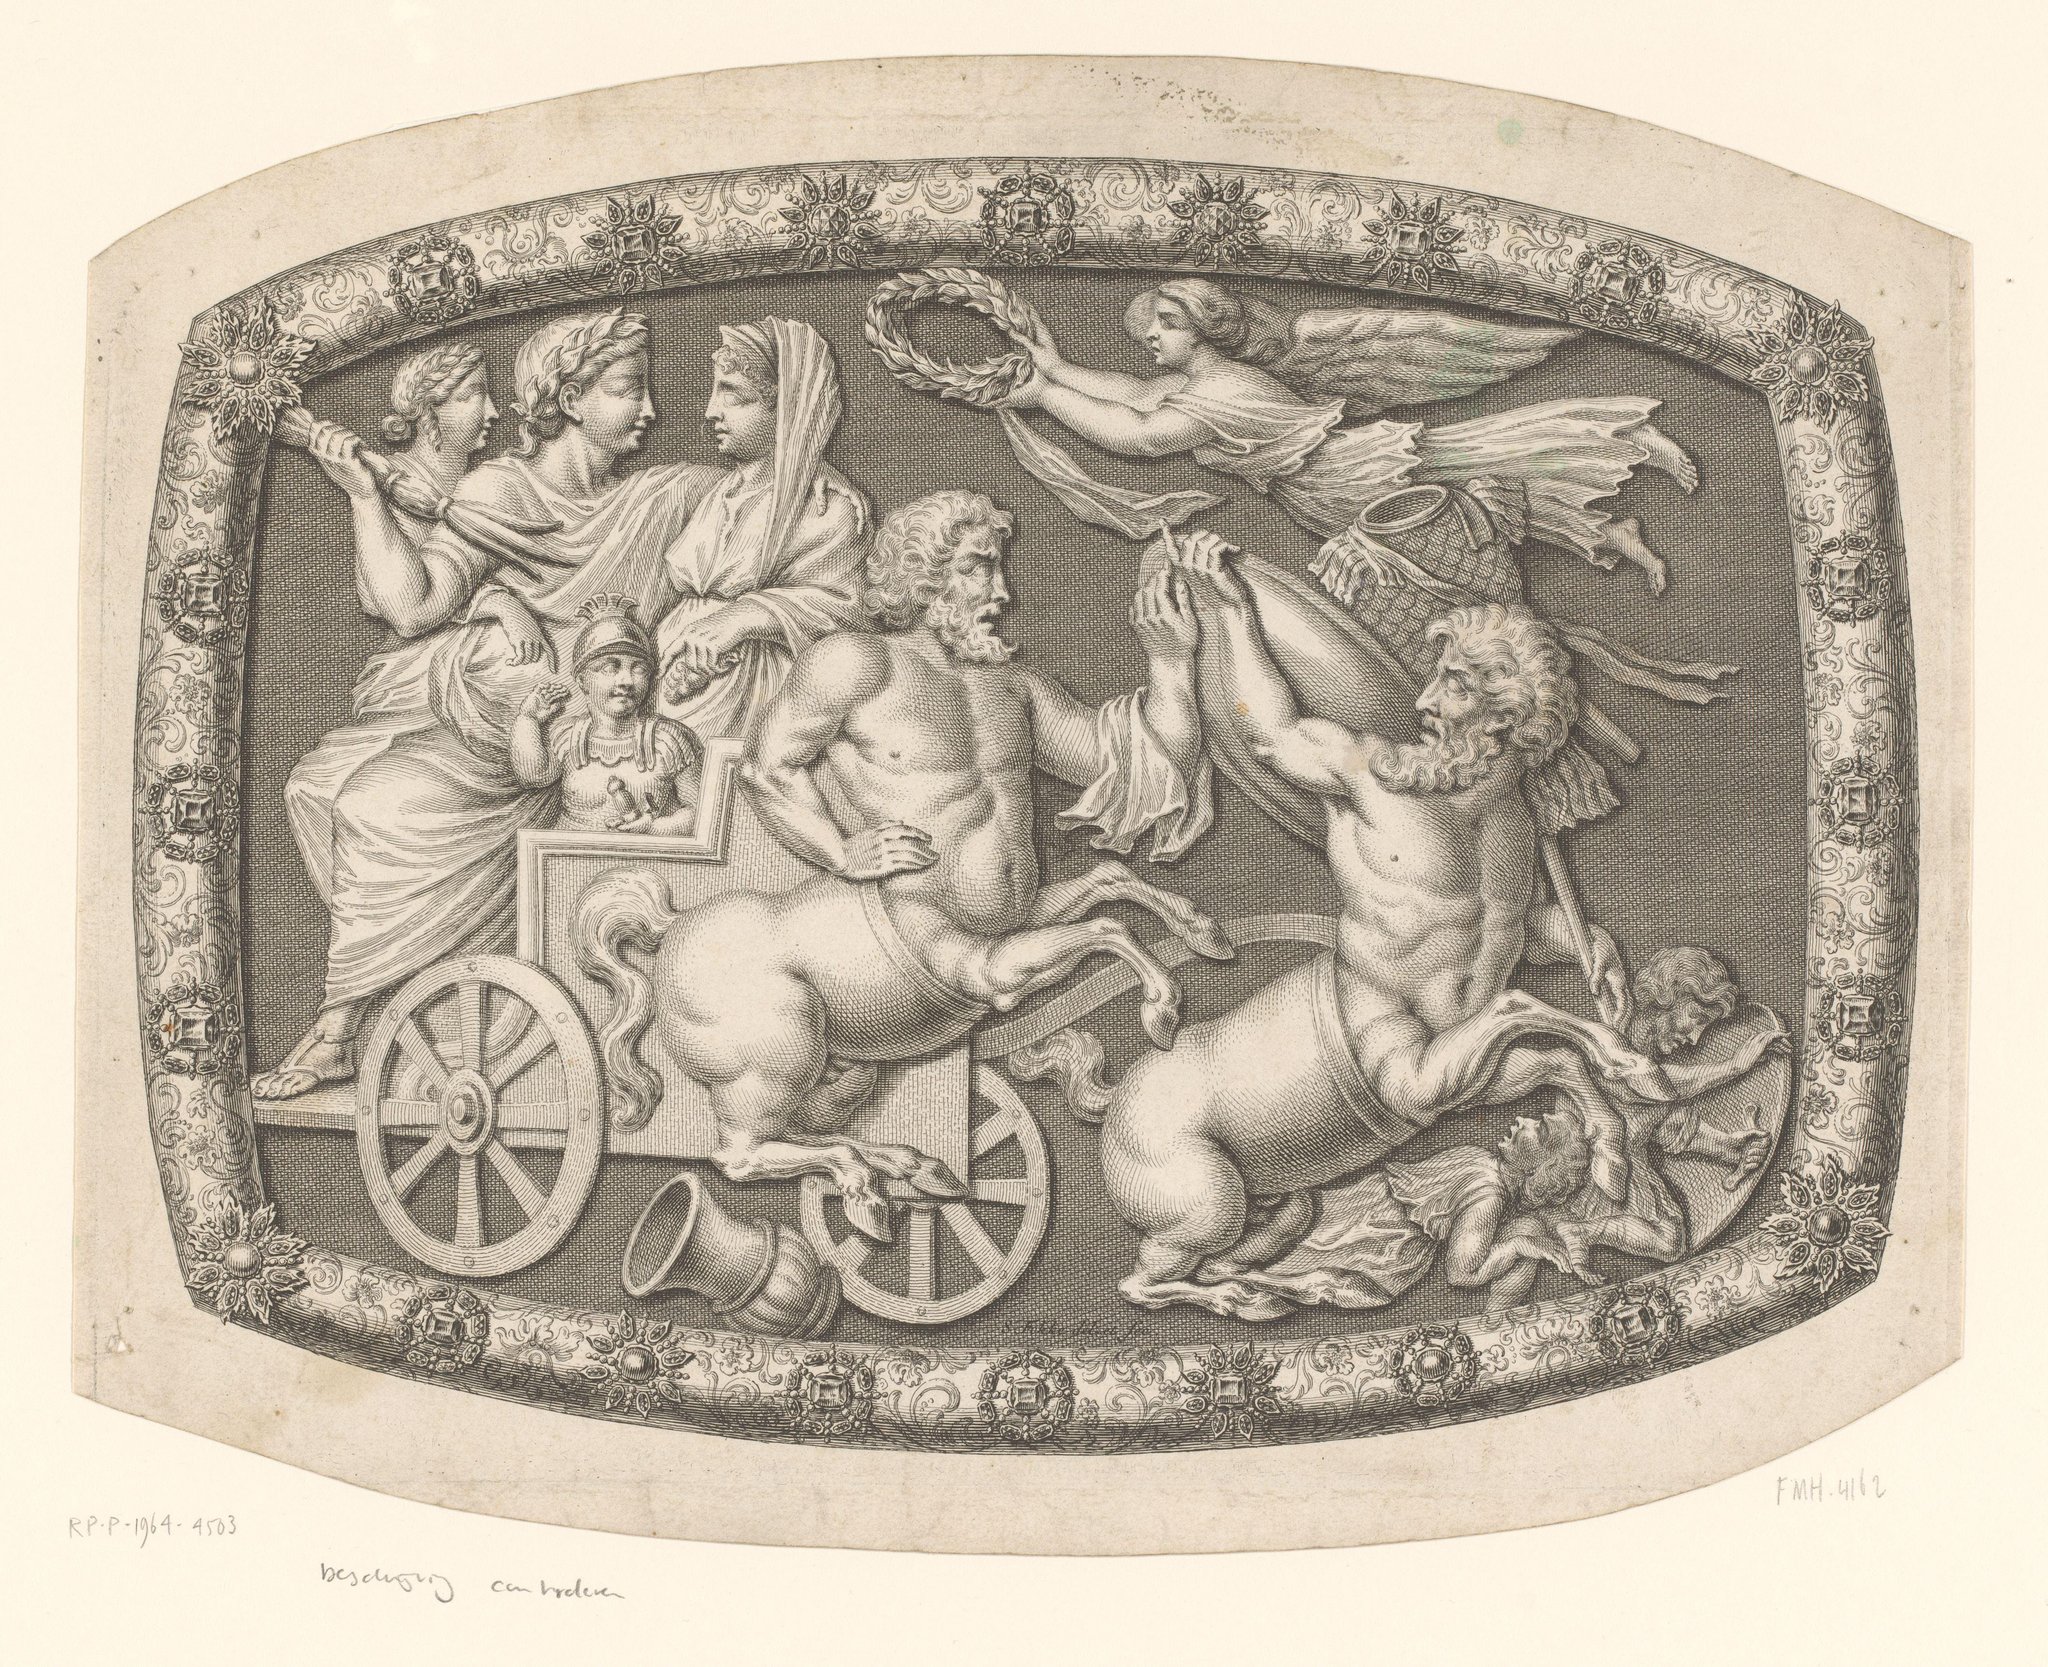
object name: print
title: Onyx met een Romeinse praalwagen en twee centauren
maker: simon fokke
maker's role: draughtsman, print maker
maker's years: 1712-1784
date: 1765-1767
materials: paper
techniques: engraving, etching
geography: amsterdam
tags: centaurs, chariot, triumphal car, ornaments, jewels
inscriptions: collector's mark: Lugt 2228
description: Een onyx met de beeltenis van een Romeinse praalwagen waarop een gelauwerde man met vrouw en kind zit. Voor de kar lopen twee centauren, in de lucht vliegt een engel met een lauwerkrans. Rond de onyx een rijkversierde lijst. De onyx zou op 11 september 1765 in de Munt te Amsterdam worden verkocht.